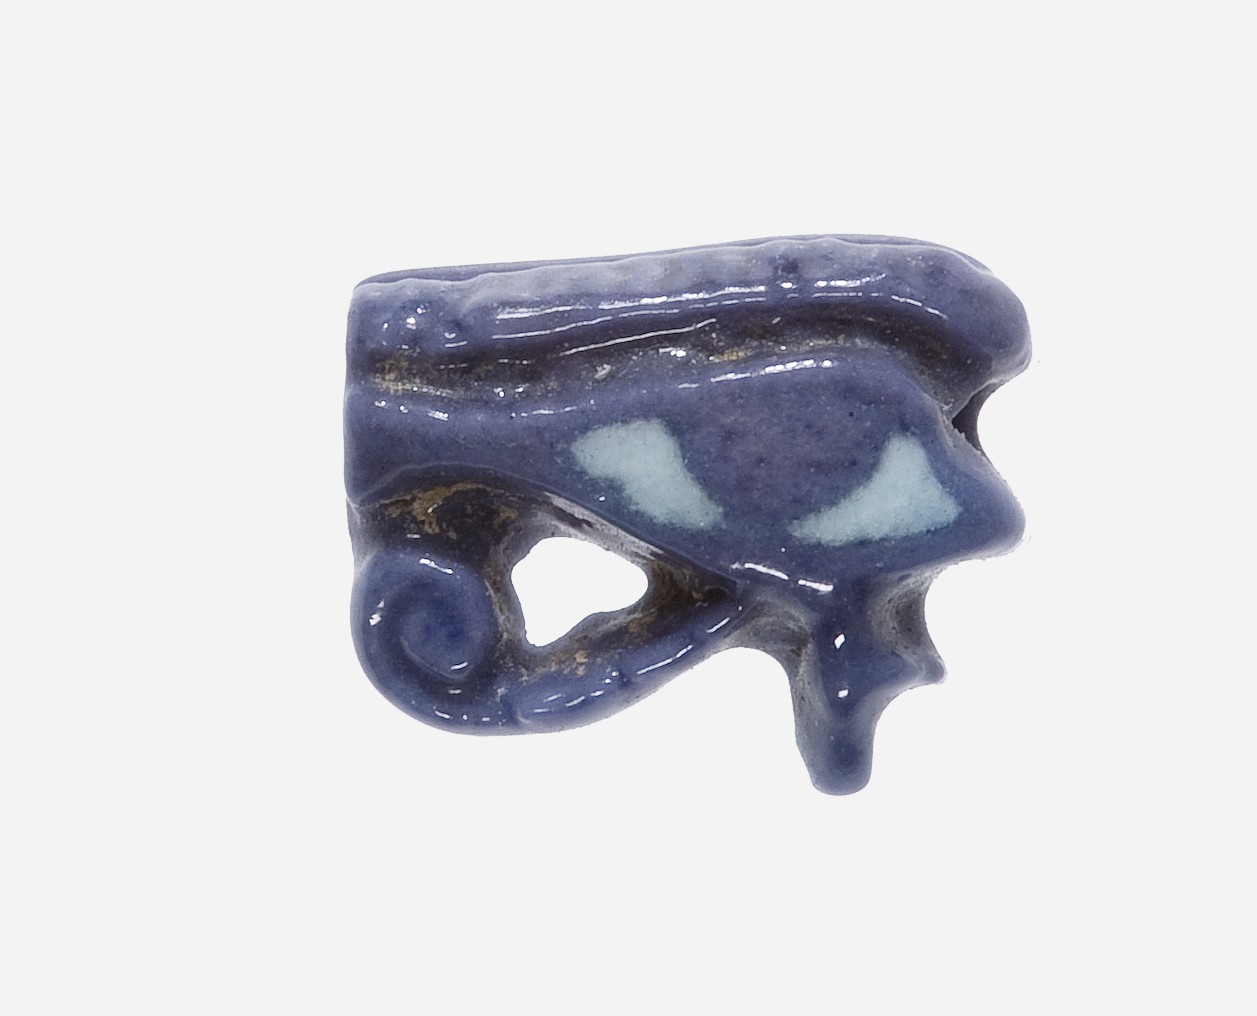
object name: amulet, wedjat eye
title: Wedjat Eye Amulet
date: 1390-1352 BCE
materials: faience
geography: egypt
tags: eyes